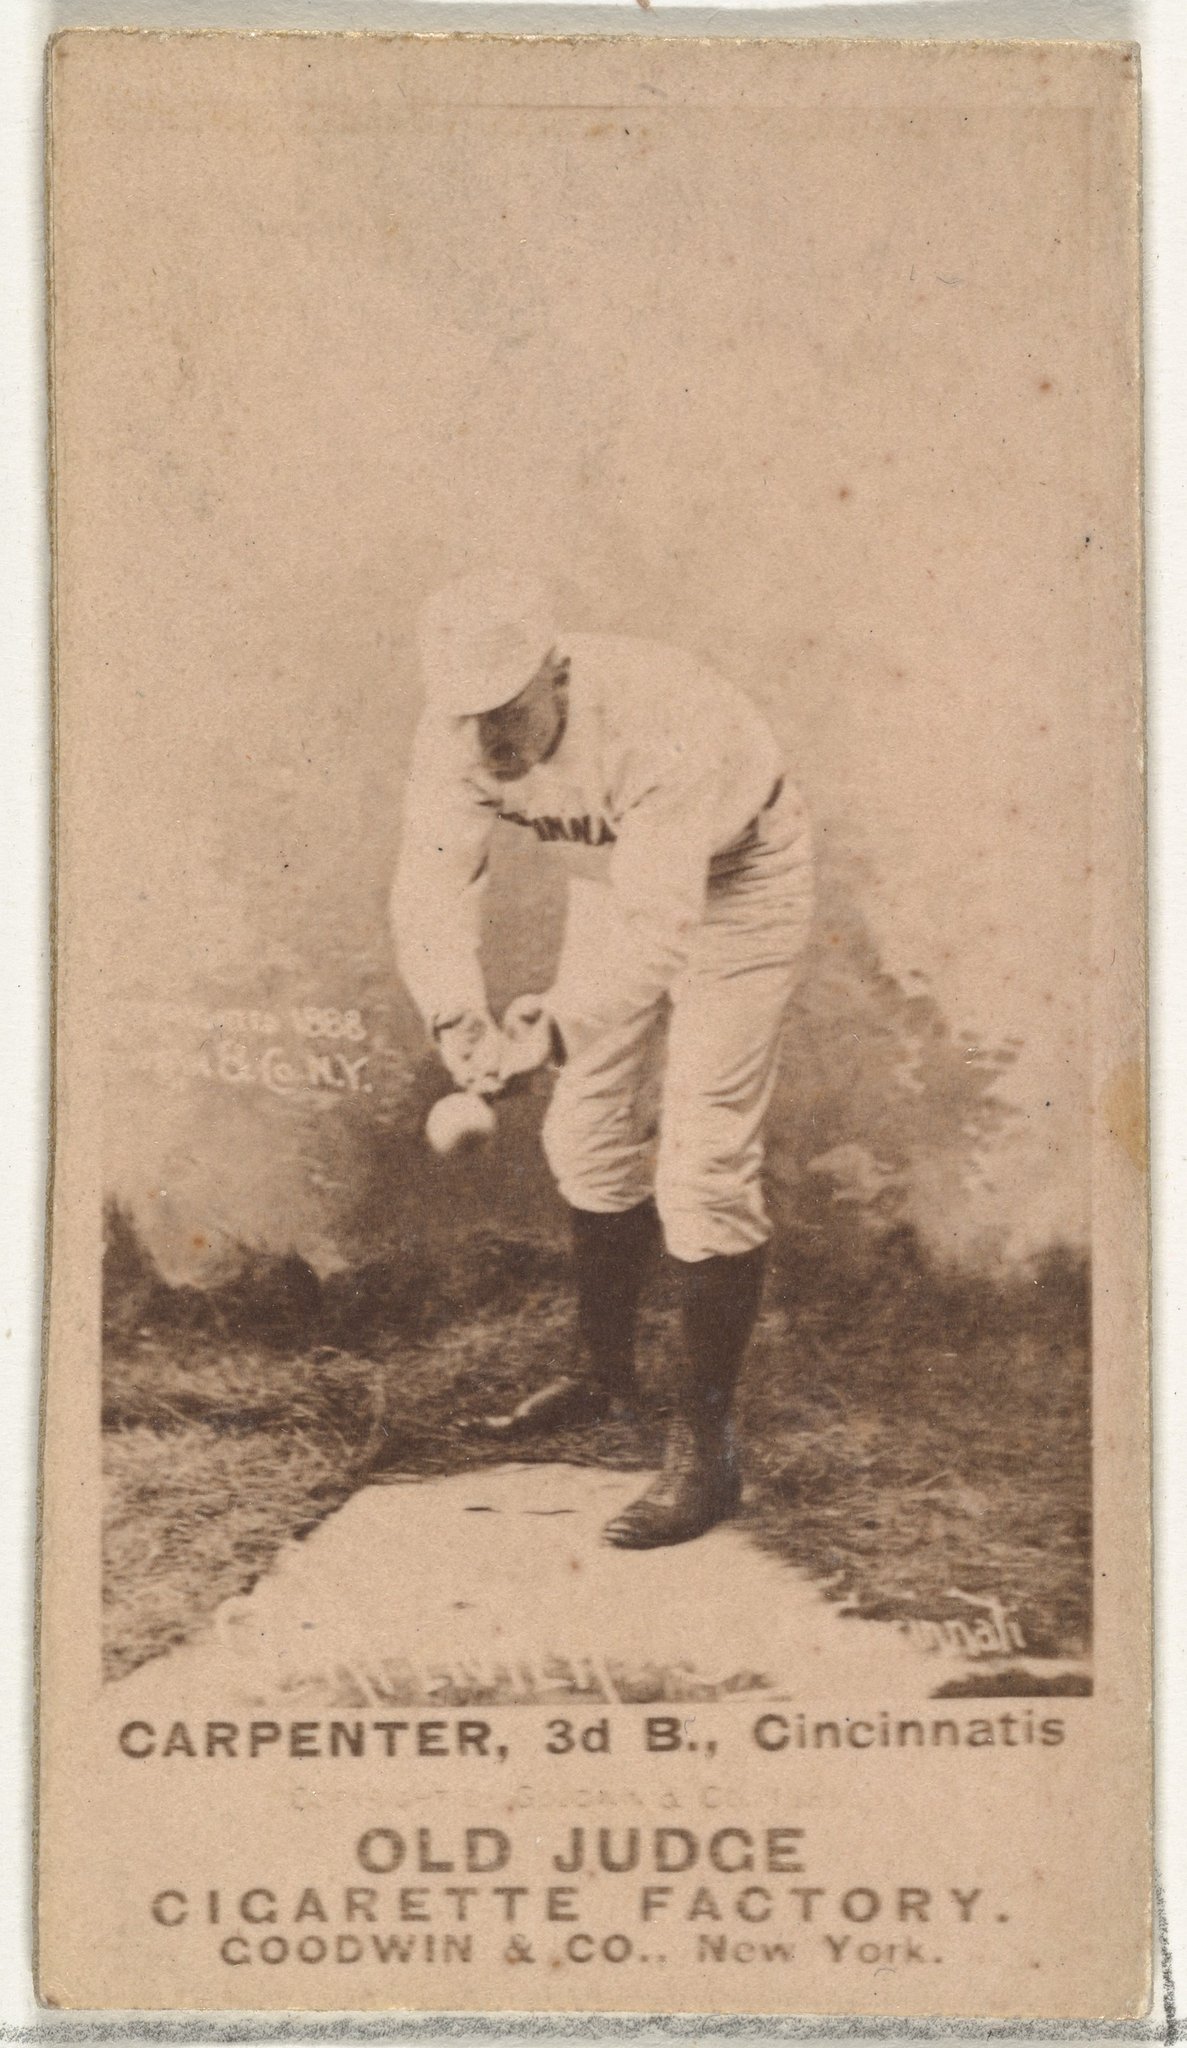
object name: baseball card, photograph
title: Warren William "Hick" Carpenter, 3rd Base, Cincinnati, from the Old Judge series (N172) for Old Judge Cigarettes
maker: goodwin & company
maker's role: publisher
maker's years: 1850-1950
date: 1888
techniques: albumen silver print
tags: men,portraits,baseball,athletes